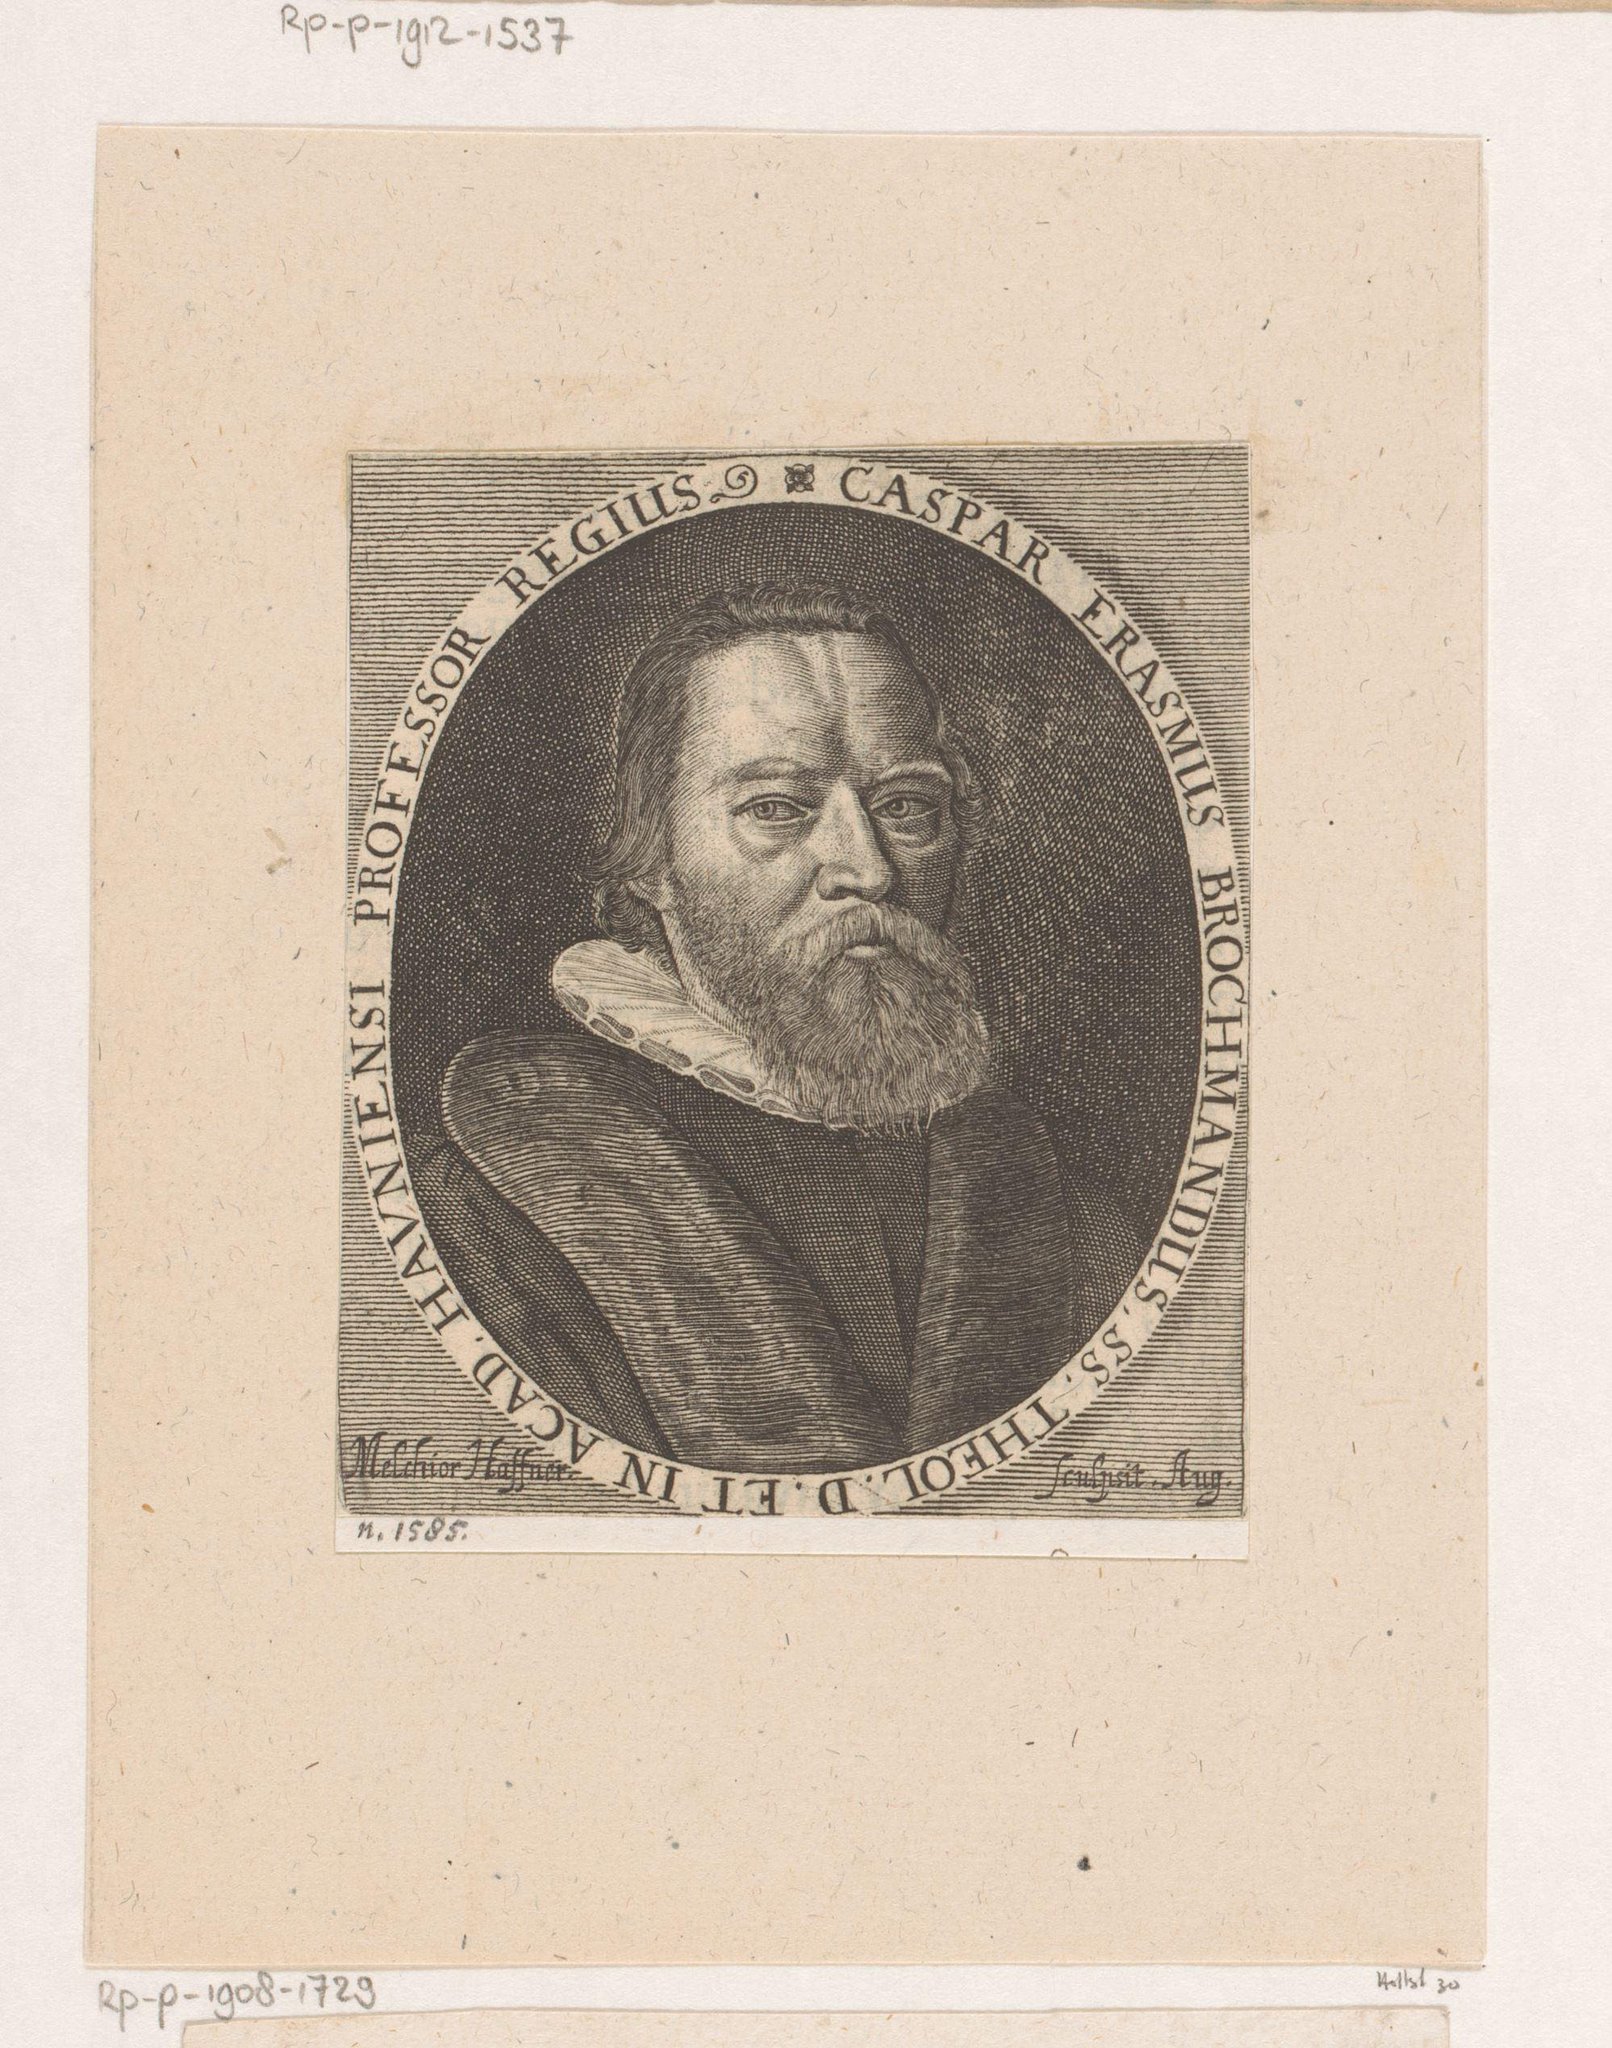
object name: print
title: Portret van Jesper Rasmussen Brochmand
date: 1673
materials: paper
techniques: engraving, letterpress printing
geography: augsburg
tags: copenhagen (city), theologian, historical persons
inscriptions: collector's mark: Lugt 2228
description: Prent uit: Spizel, Gottlieb. Templum Honoris reseratum (...). Augsburg: Gottlieb Göbel, 1673.